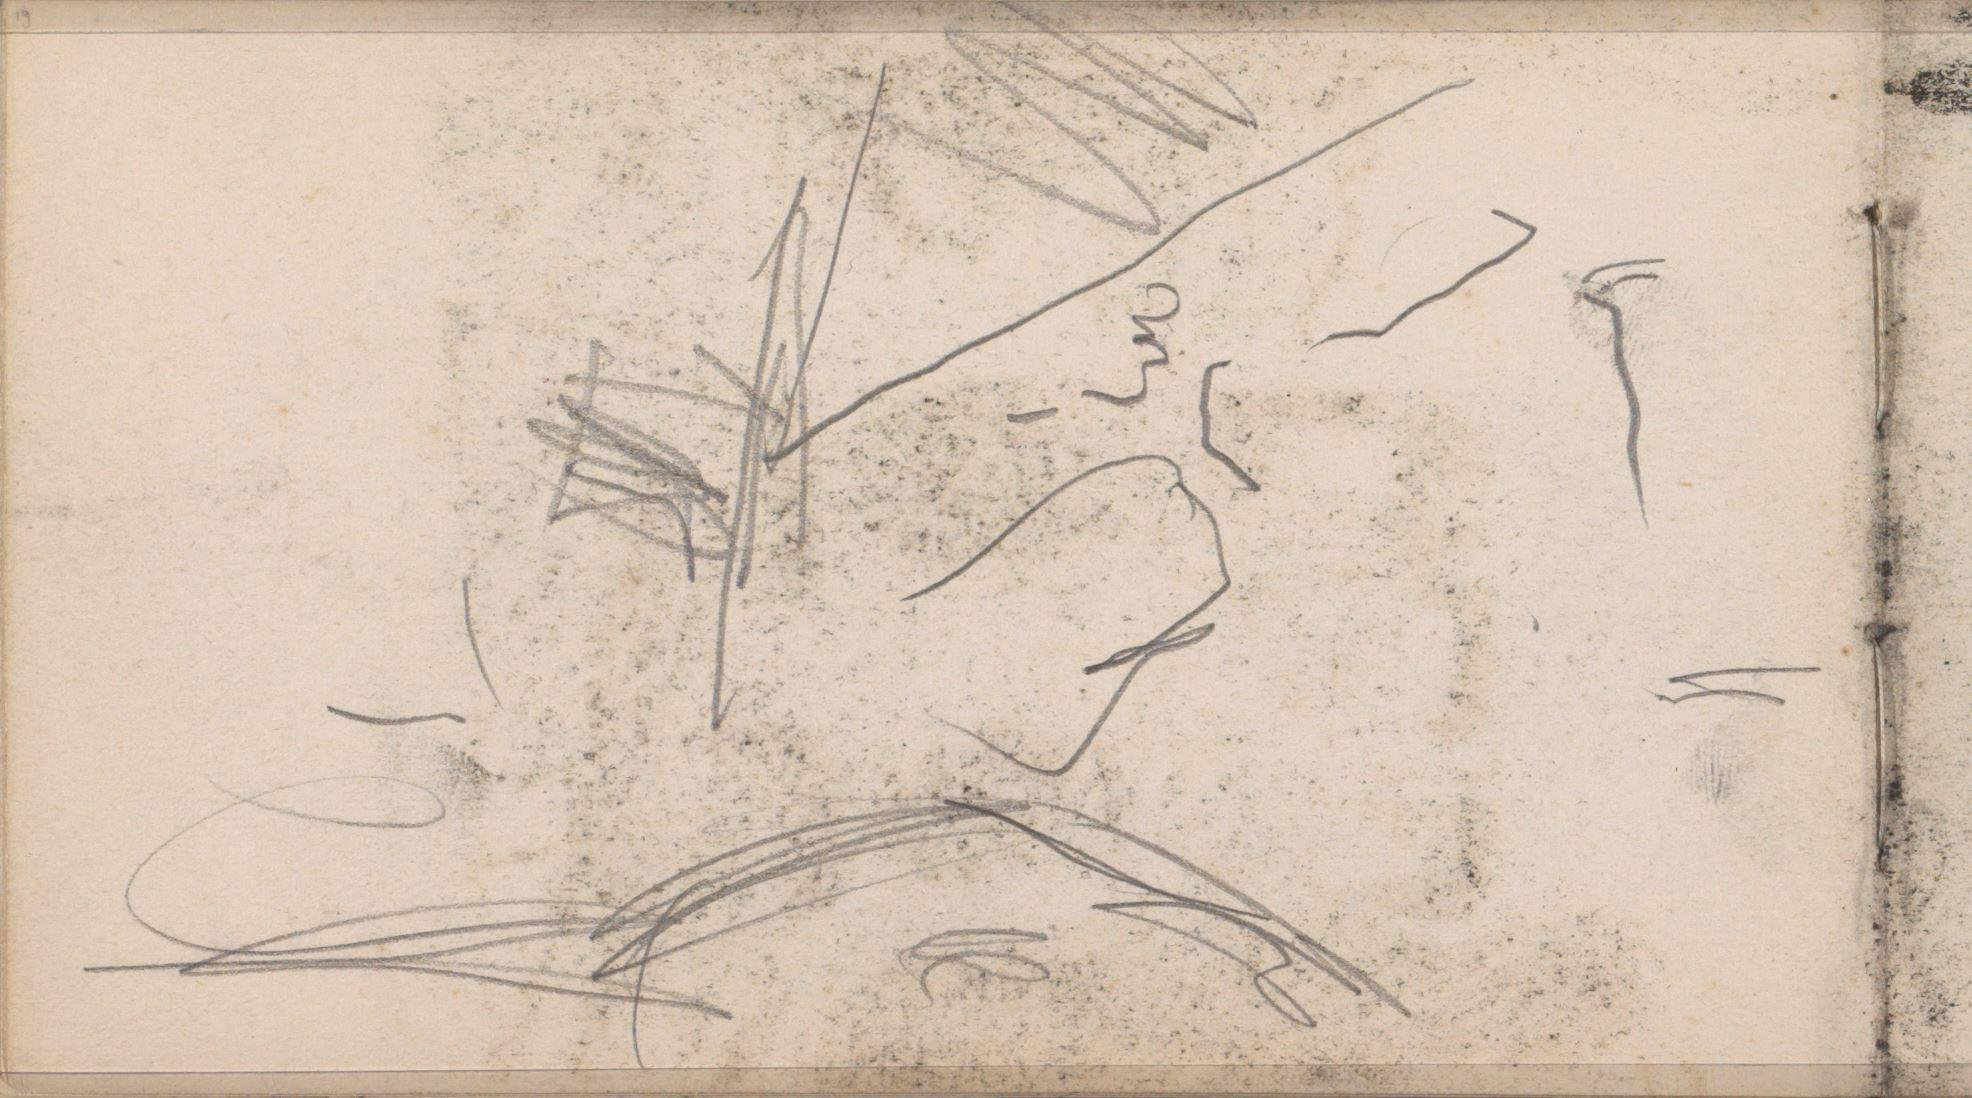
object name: sketchbook leaf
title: Studie, mogelijk van een weg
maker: george hendrik breitner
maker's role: draughtsman, painter, print maker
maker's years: 1857-1923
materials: paper, pencil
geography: amsterdam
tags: road, path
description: Pagina 19 uit een schetsboek met 32 bladen.